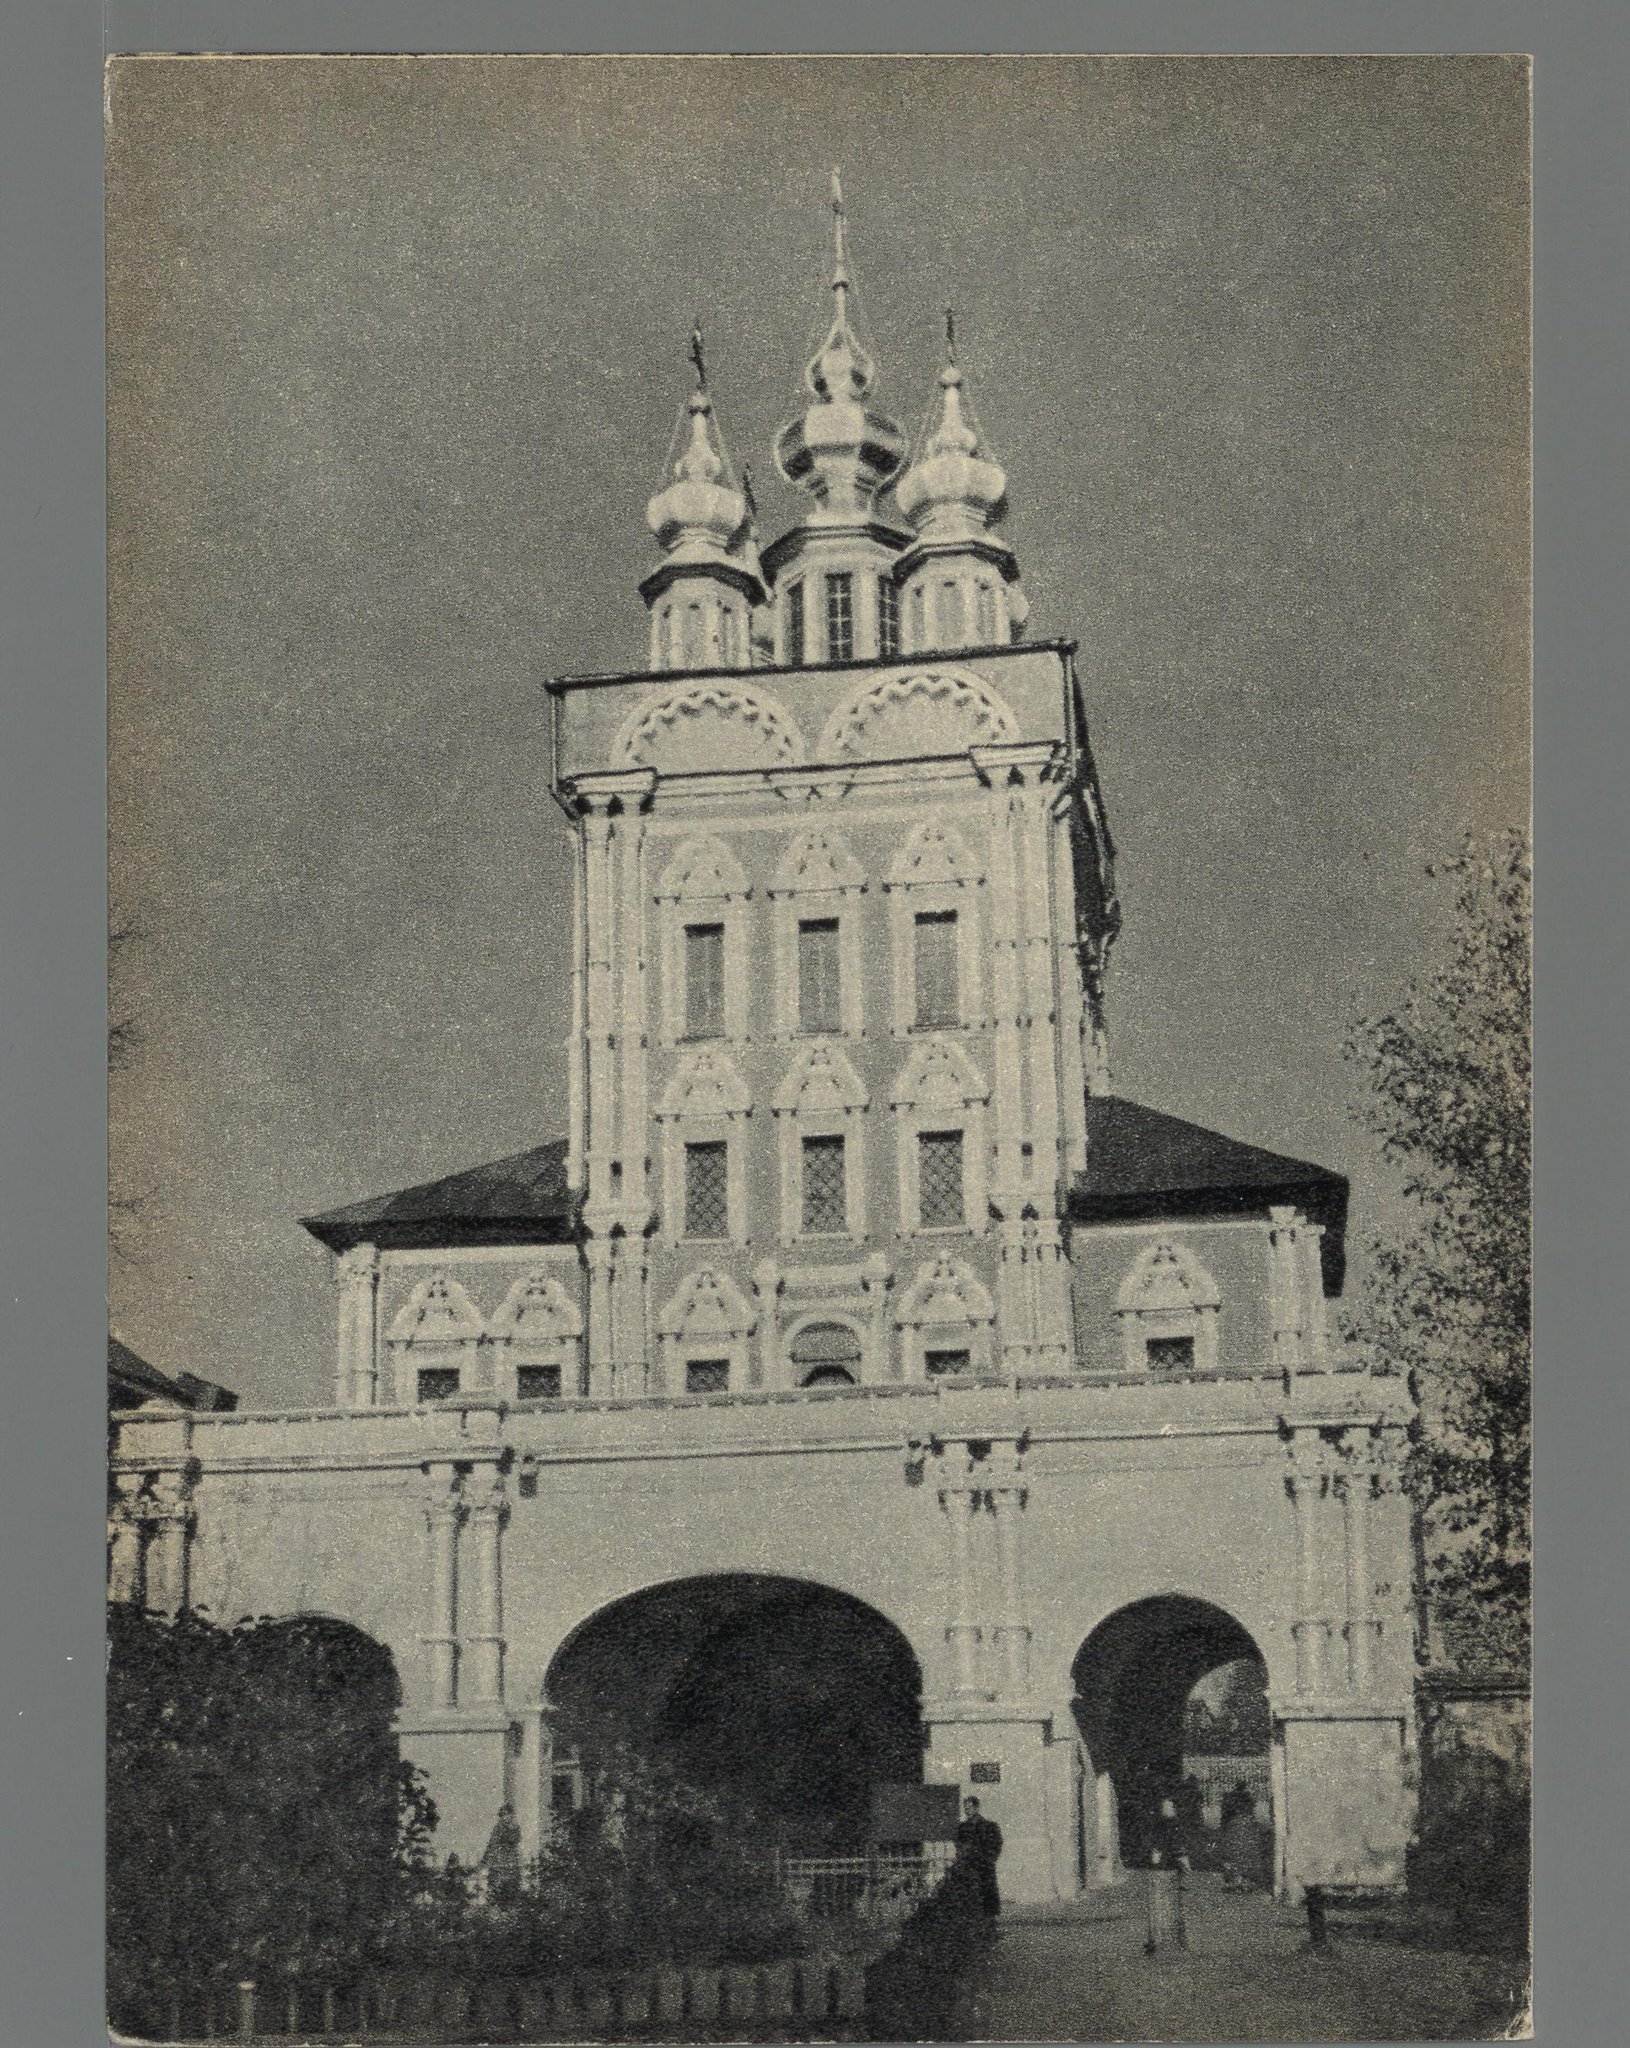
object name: ansichtkaart, prentbriefkaart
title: Gezicht op het Novodevitsjiklooster bij de noordelijke poort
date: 1957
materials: cardboard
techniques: rotogravure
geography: moscow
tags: abbey, monastery, convent ~ roman catholic church, gate, entrance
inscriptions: date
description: De titel op object staat in het Russisch.